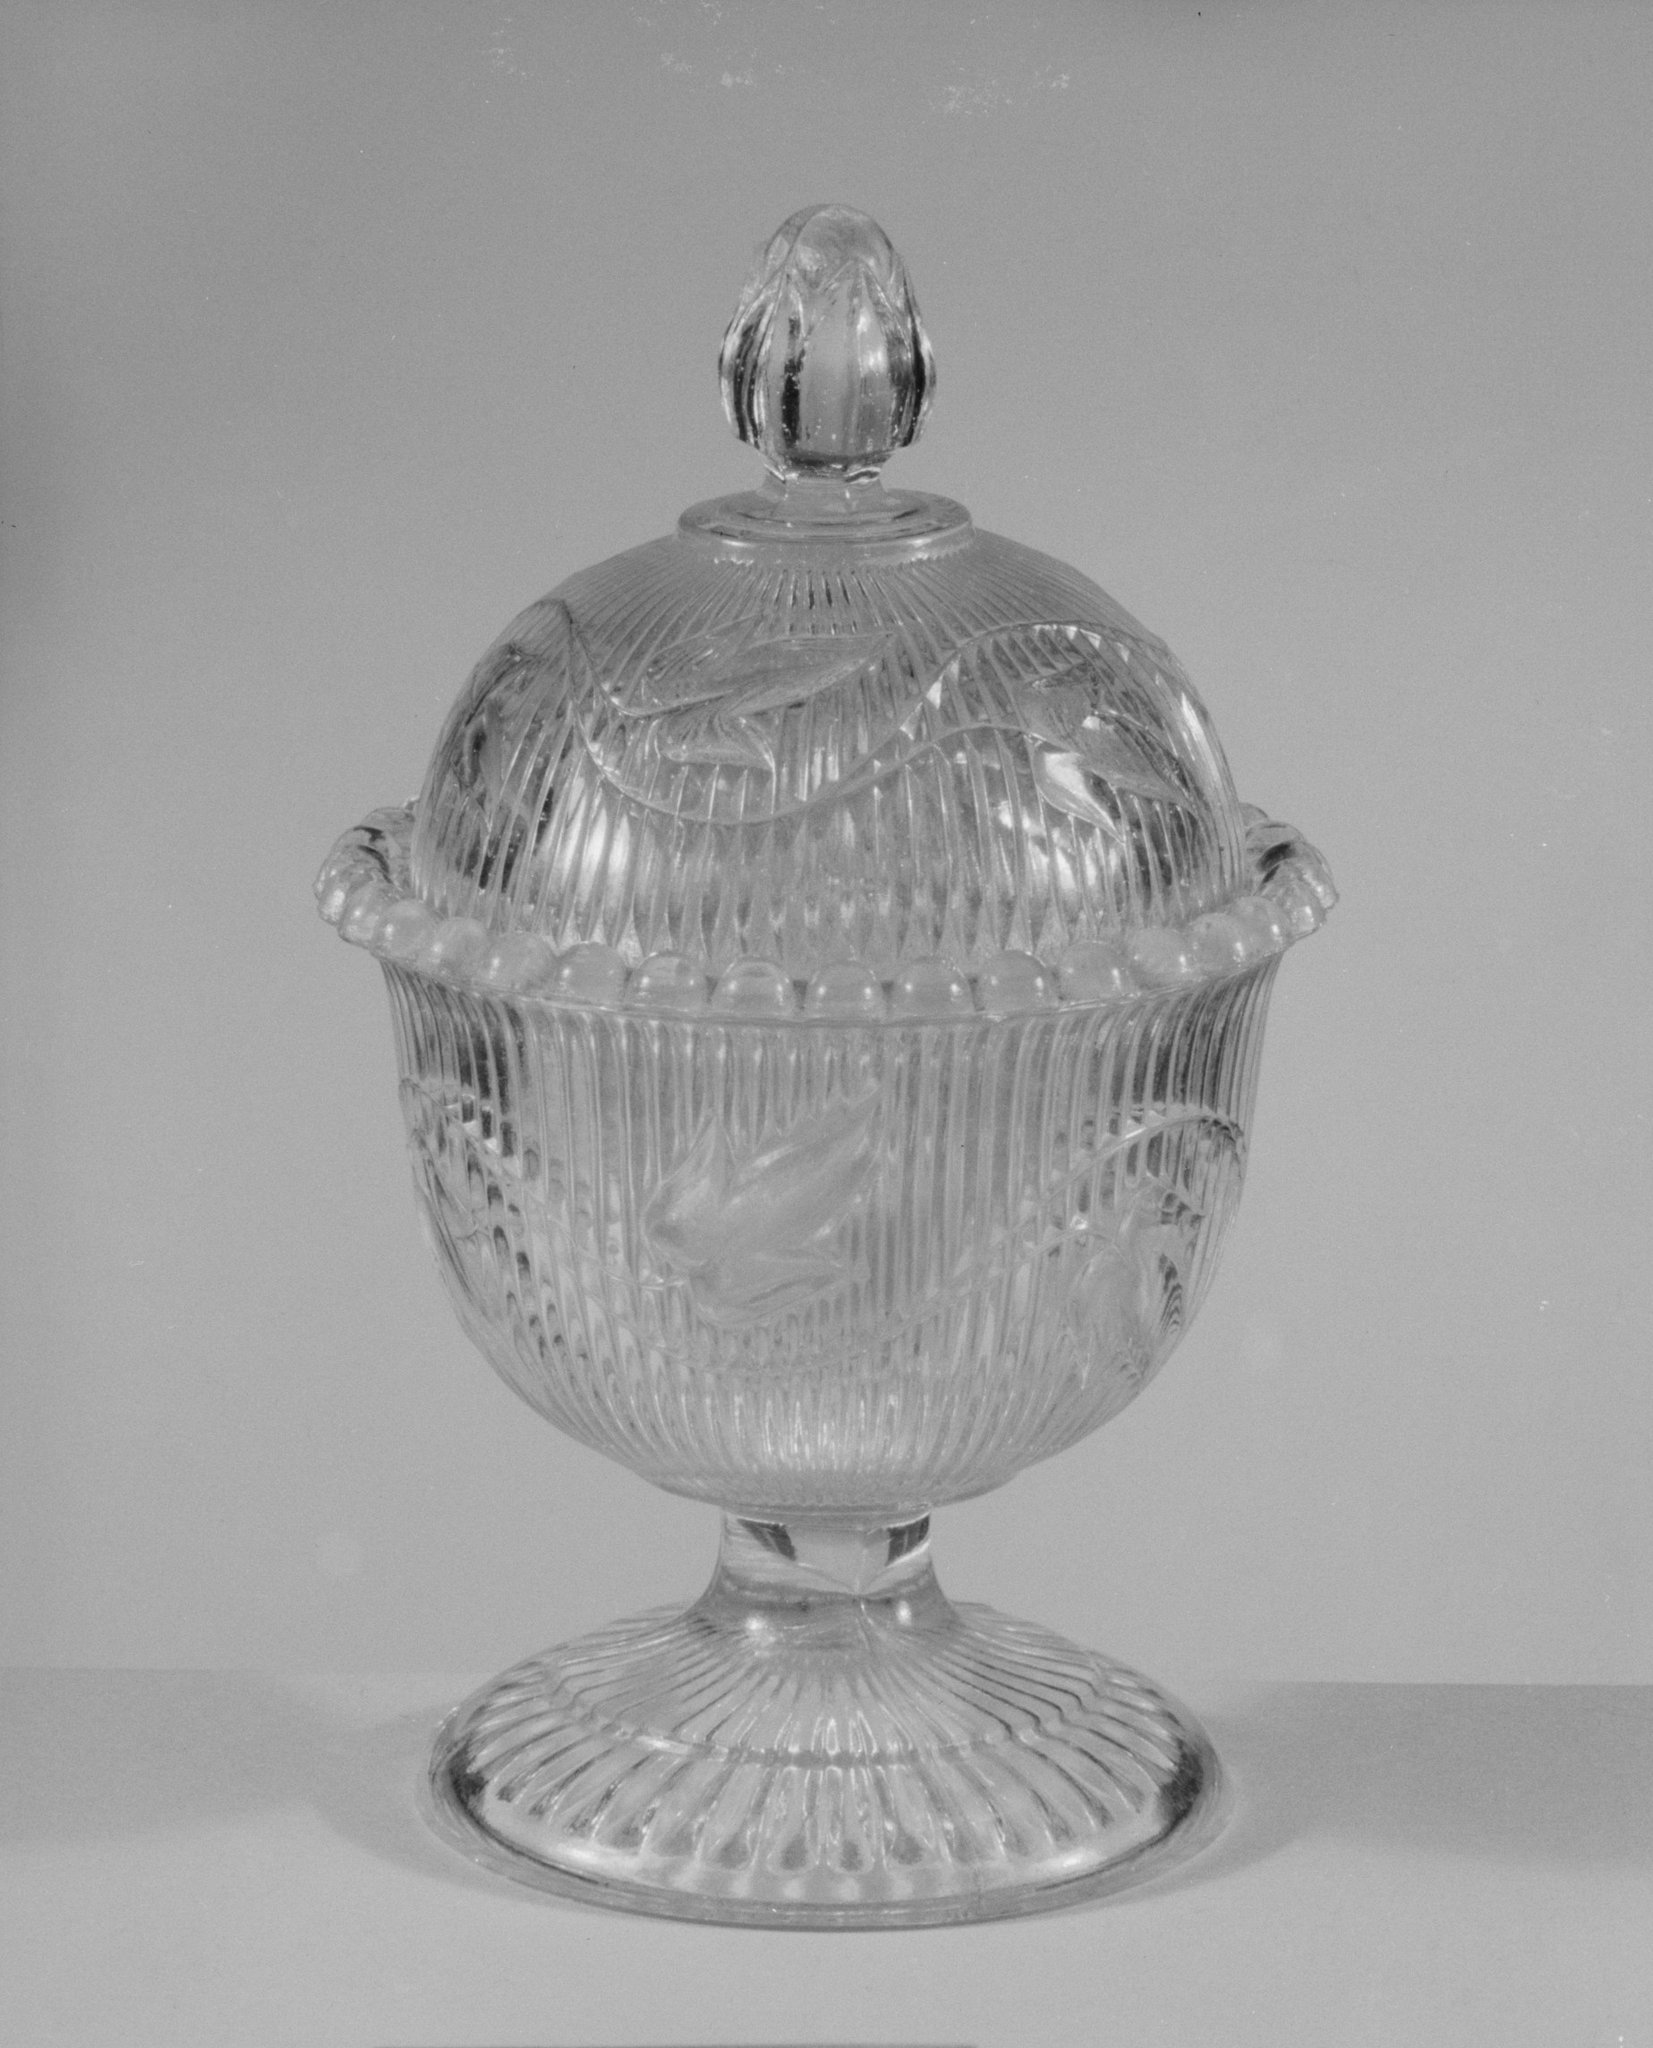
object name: saltcellar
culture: american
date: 1855-1865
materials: glass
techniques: pressed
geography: united states